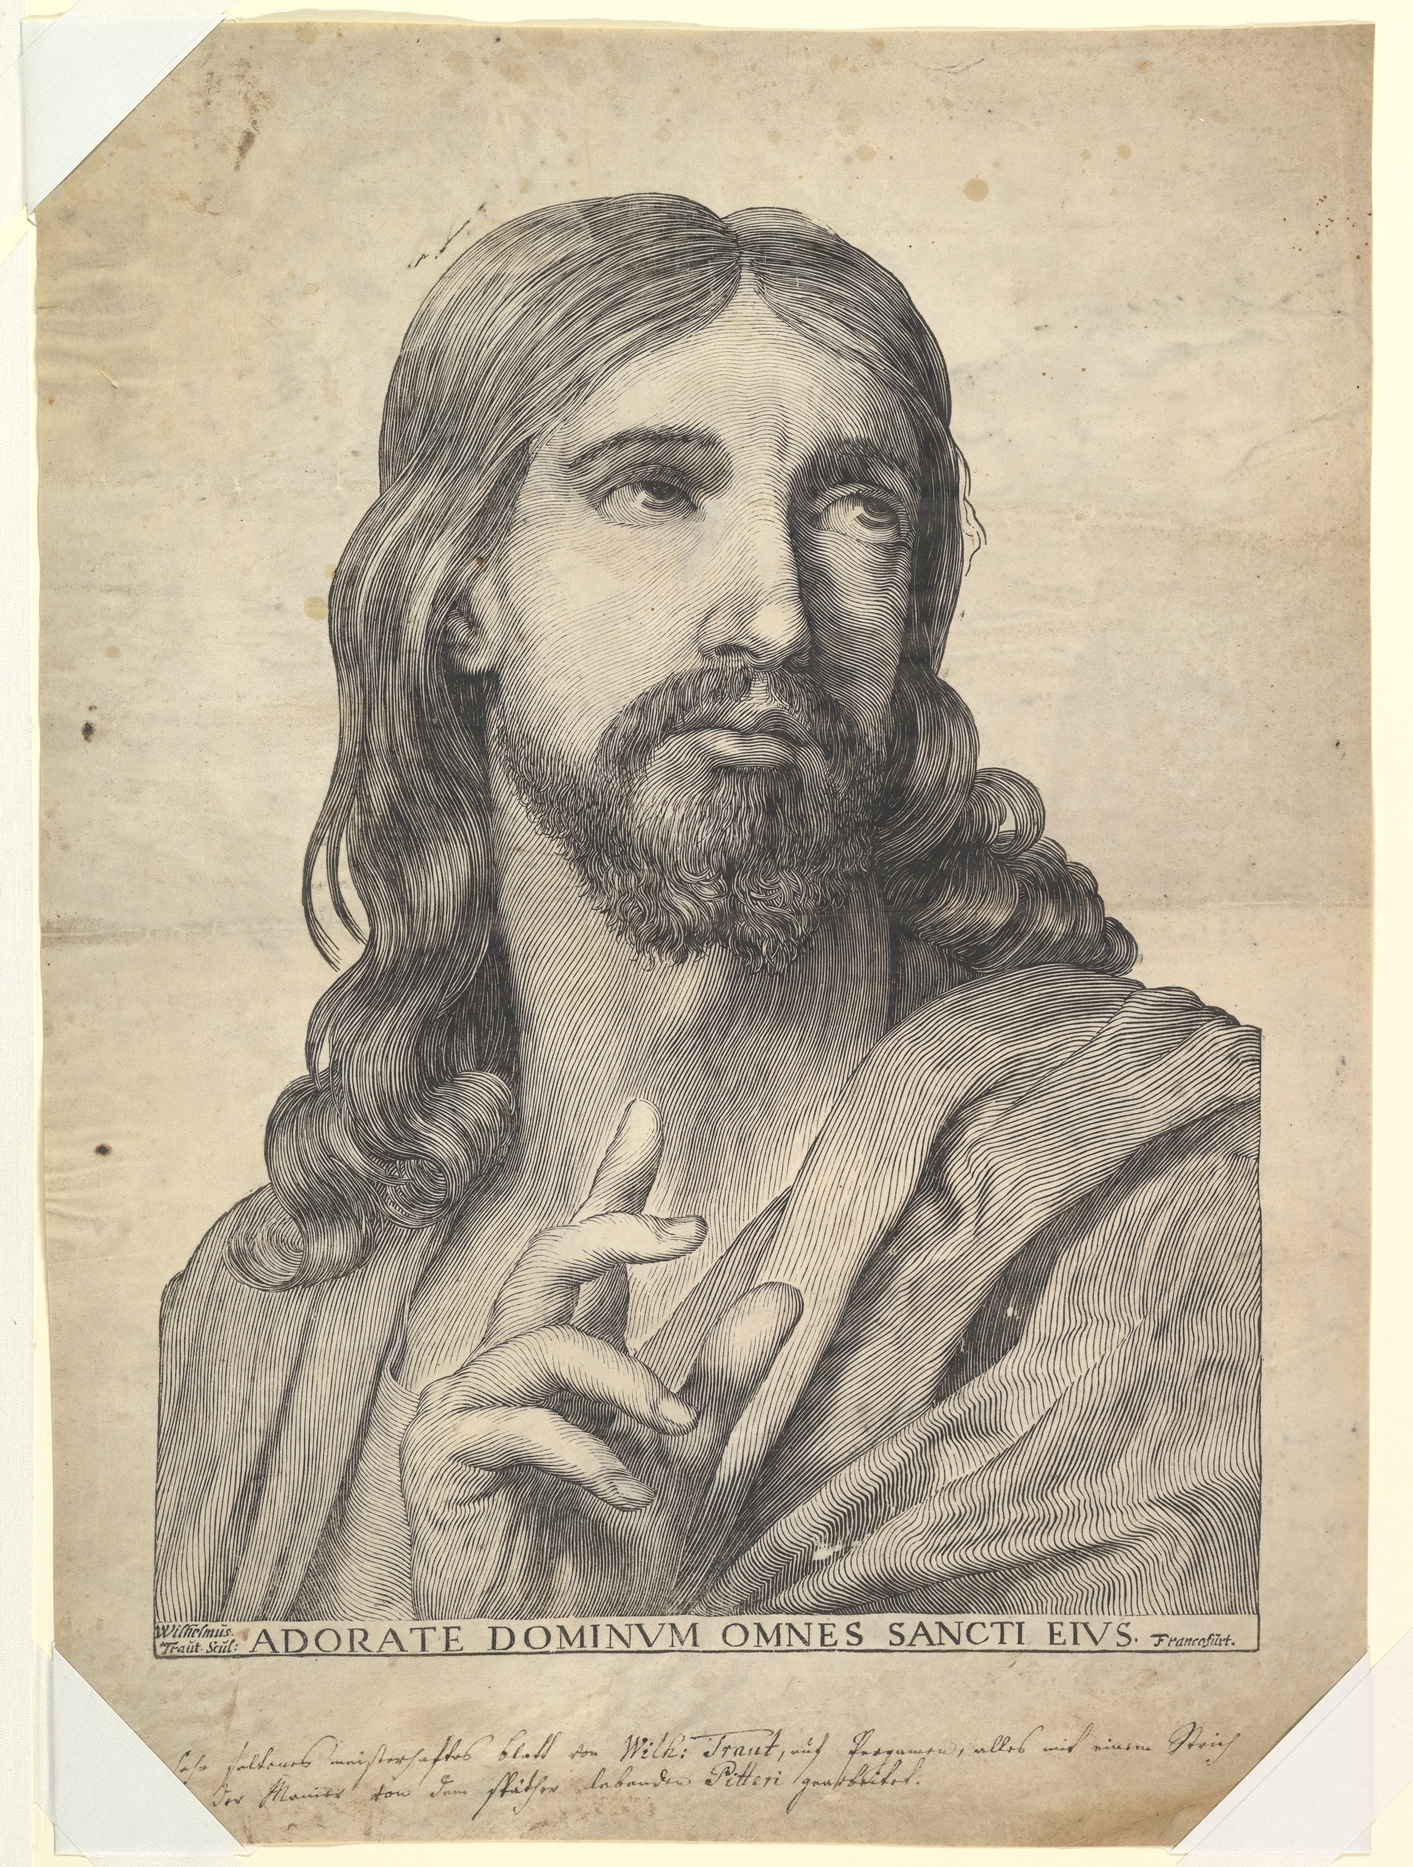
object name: print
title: Bust of Christ Blessing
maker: wilhelm traut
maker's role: artist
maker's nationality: german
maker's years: 1650-1662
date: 1601-1700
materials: parchment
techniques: woodcut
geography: germany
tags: portraits,christ